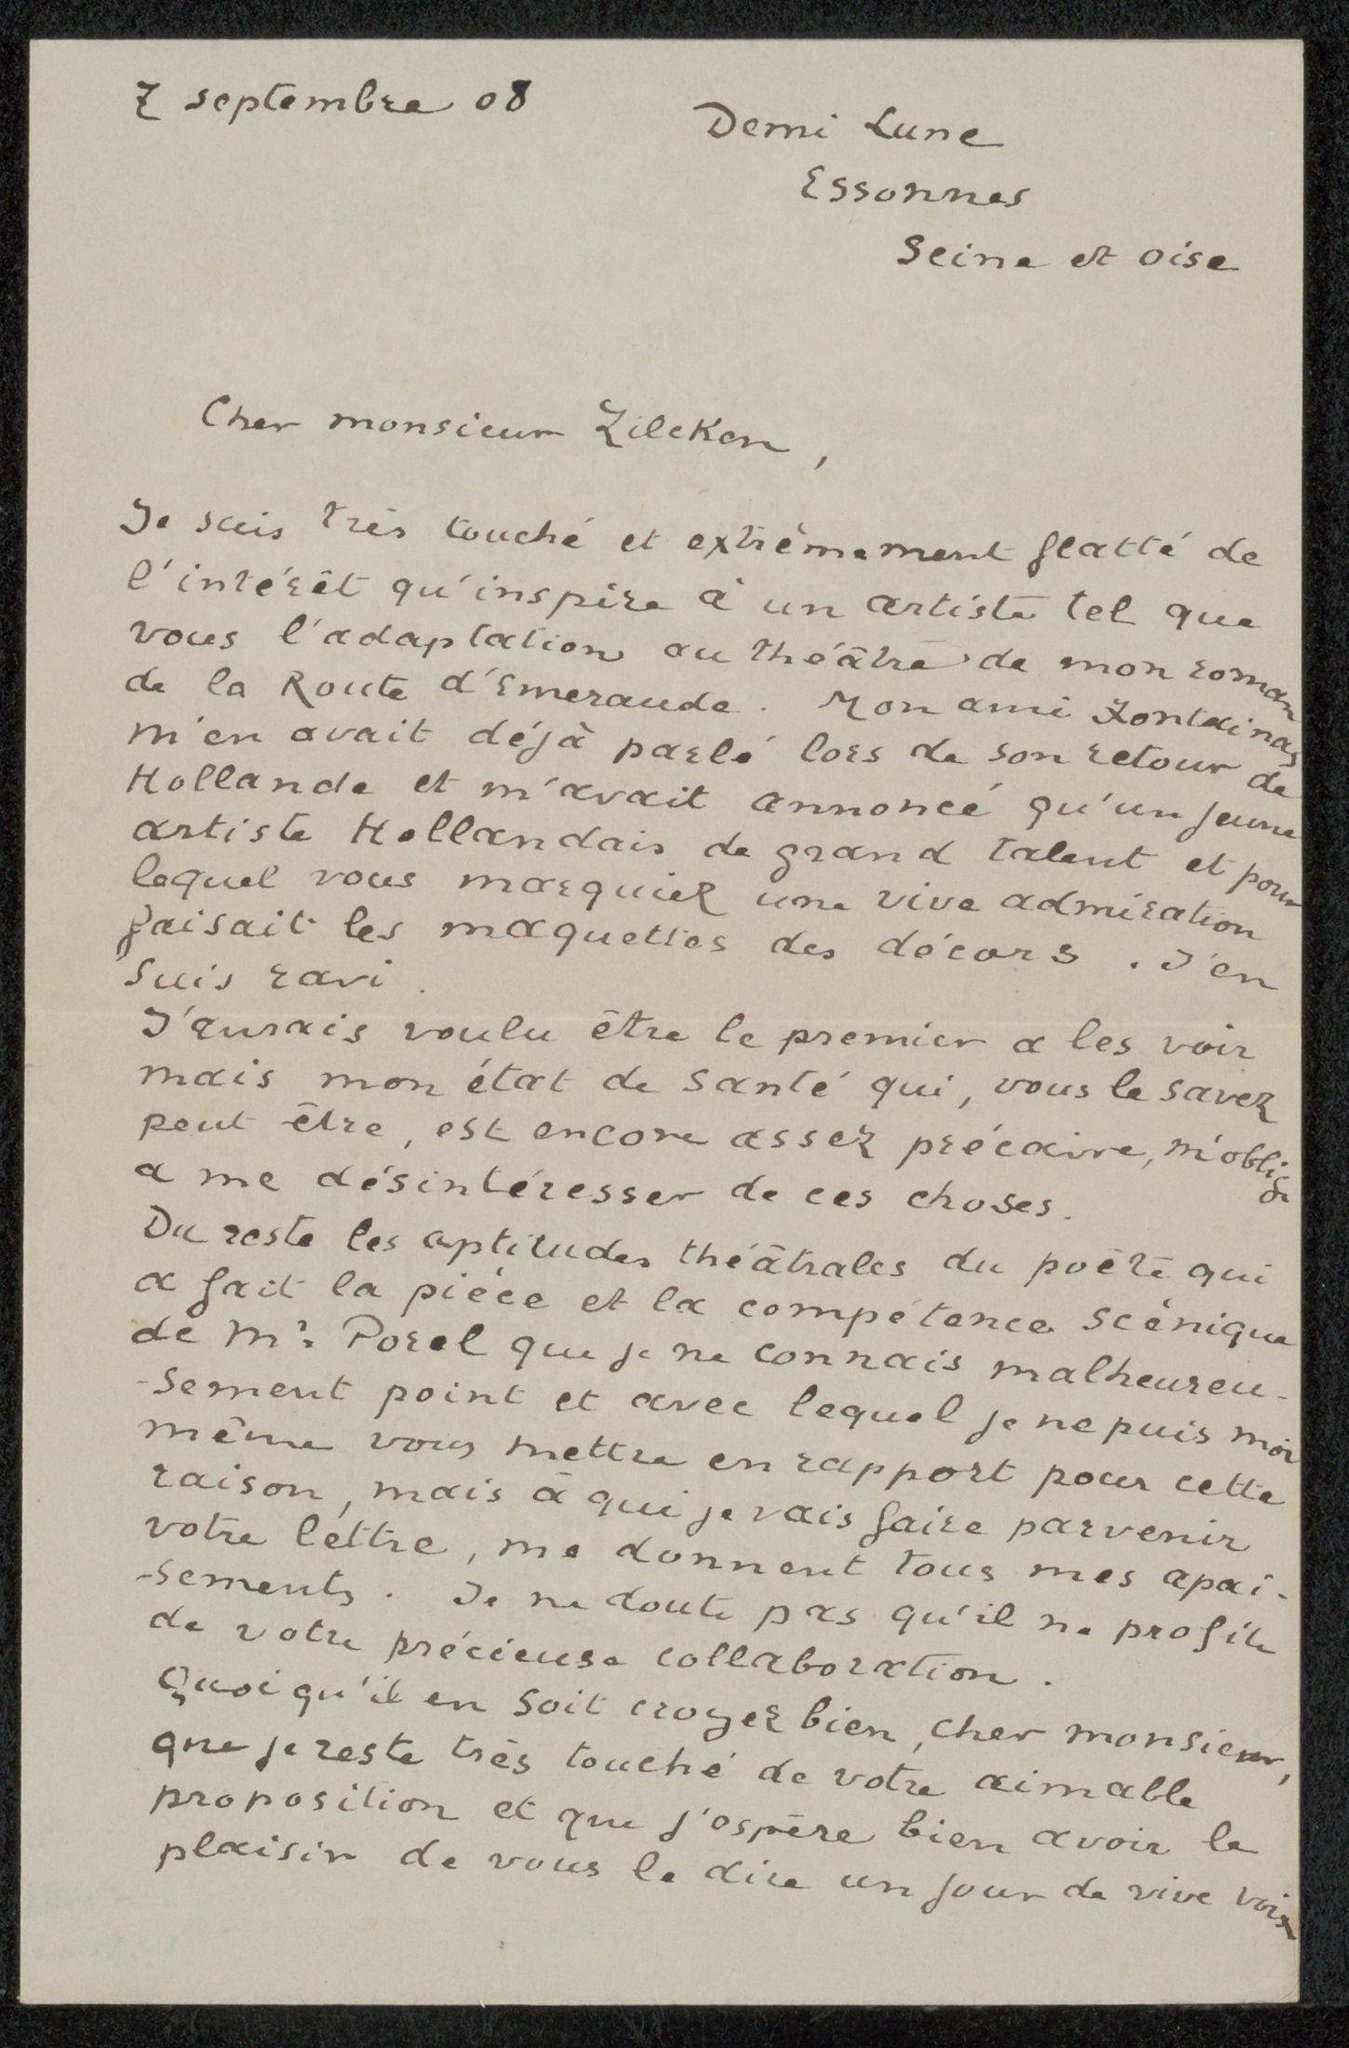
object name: letter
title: Brief aan Philip Zilcken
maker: eugène demolder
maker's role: illustrator, schrijver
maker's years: 1862-1919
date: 1908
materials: ink, paper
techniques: pen, writing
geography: corbeil-essonnes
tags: the hague, painter, draughtsman, philip zilcken, literature ~ arts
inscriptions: collector's mark: ‘RPK’